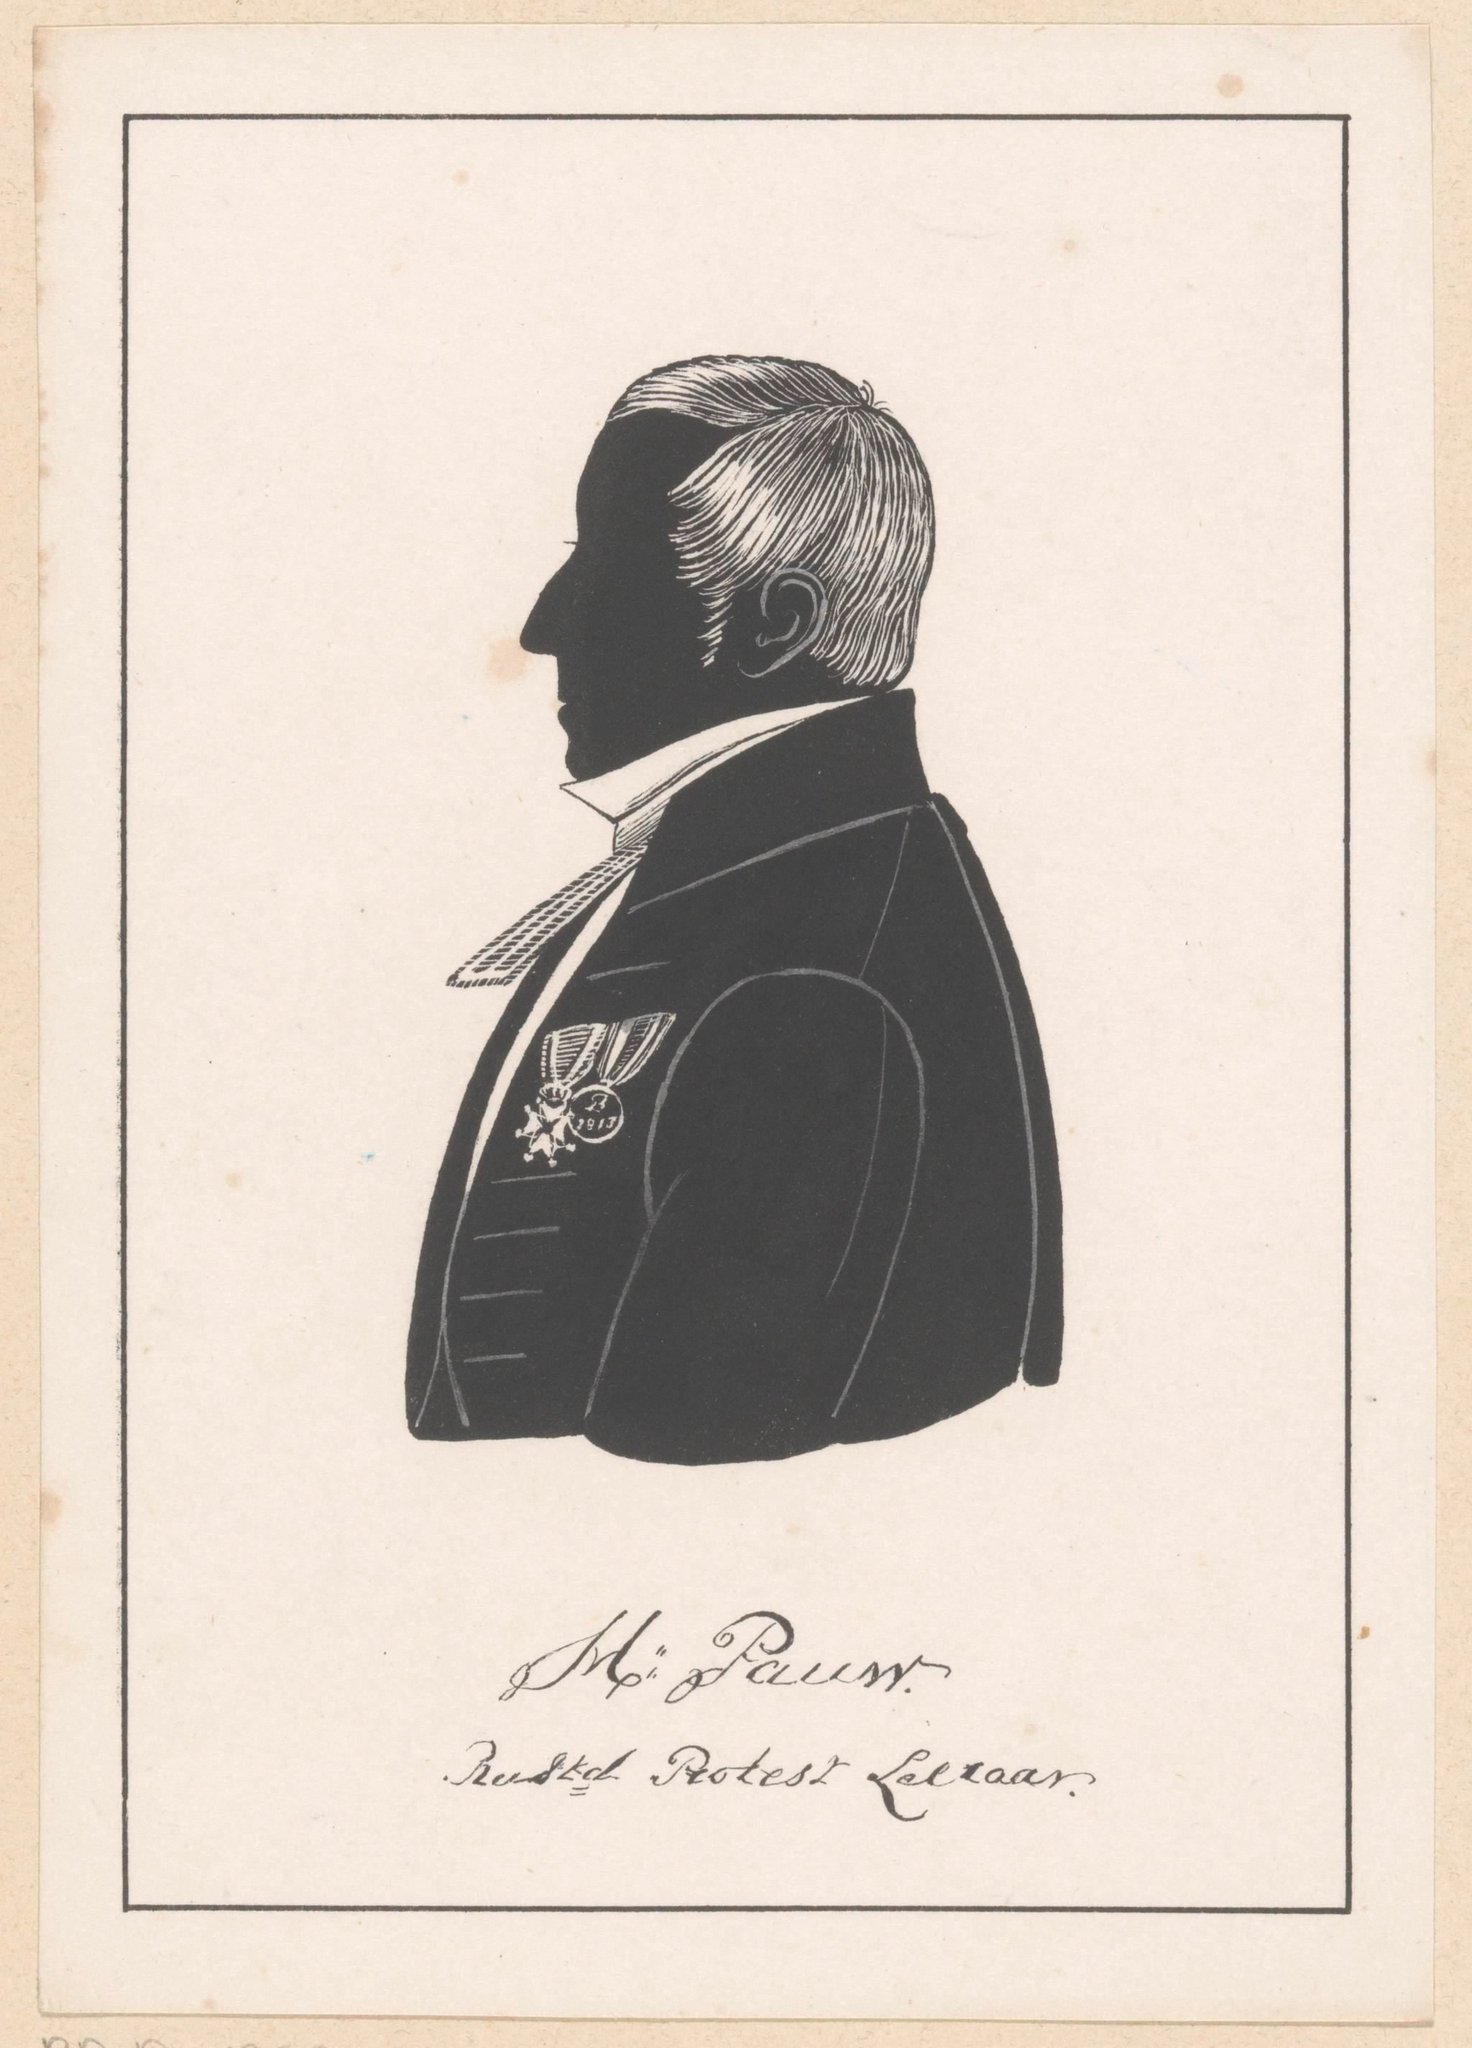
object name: print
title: Silhouetportret van H. Pauw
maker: pieter barbiers (iv)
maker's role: painter, print maker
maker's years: 1798-1848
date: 1809-1848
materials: paper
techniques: hand coloring, lithograph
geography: netherlands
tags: historical persons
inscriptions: collector's mark: Lugt 2228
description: Onder het portret de signatuur van de geportretteerde en de toevoeging Rustend Protest(ants) Leraar.